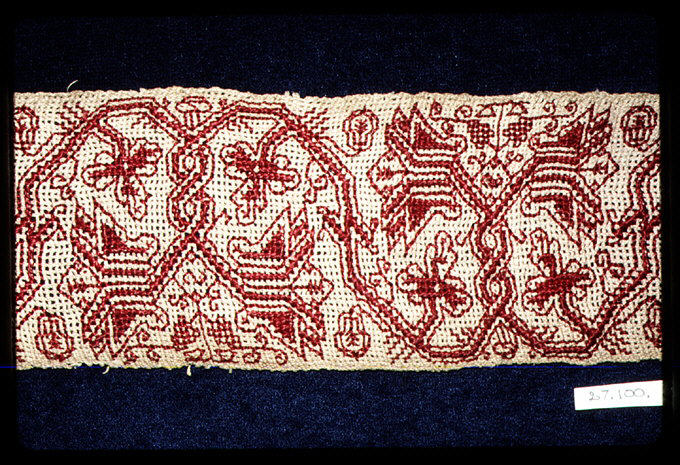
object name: strip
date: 1501-1600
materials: linen, silk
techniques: embroidery